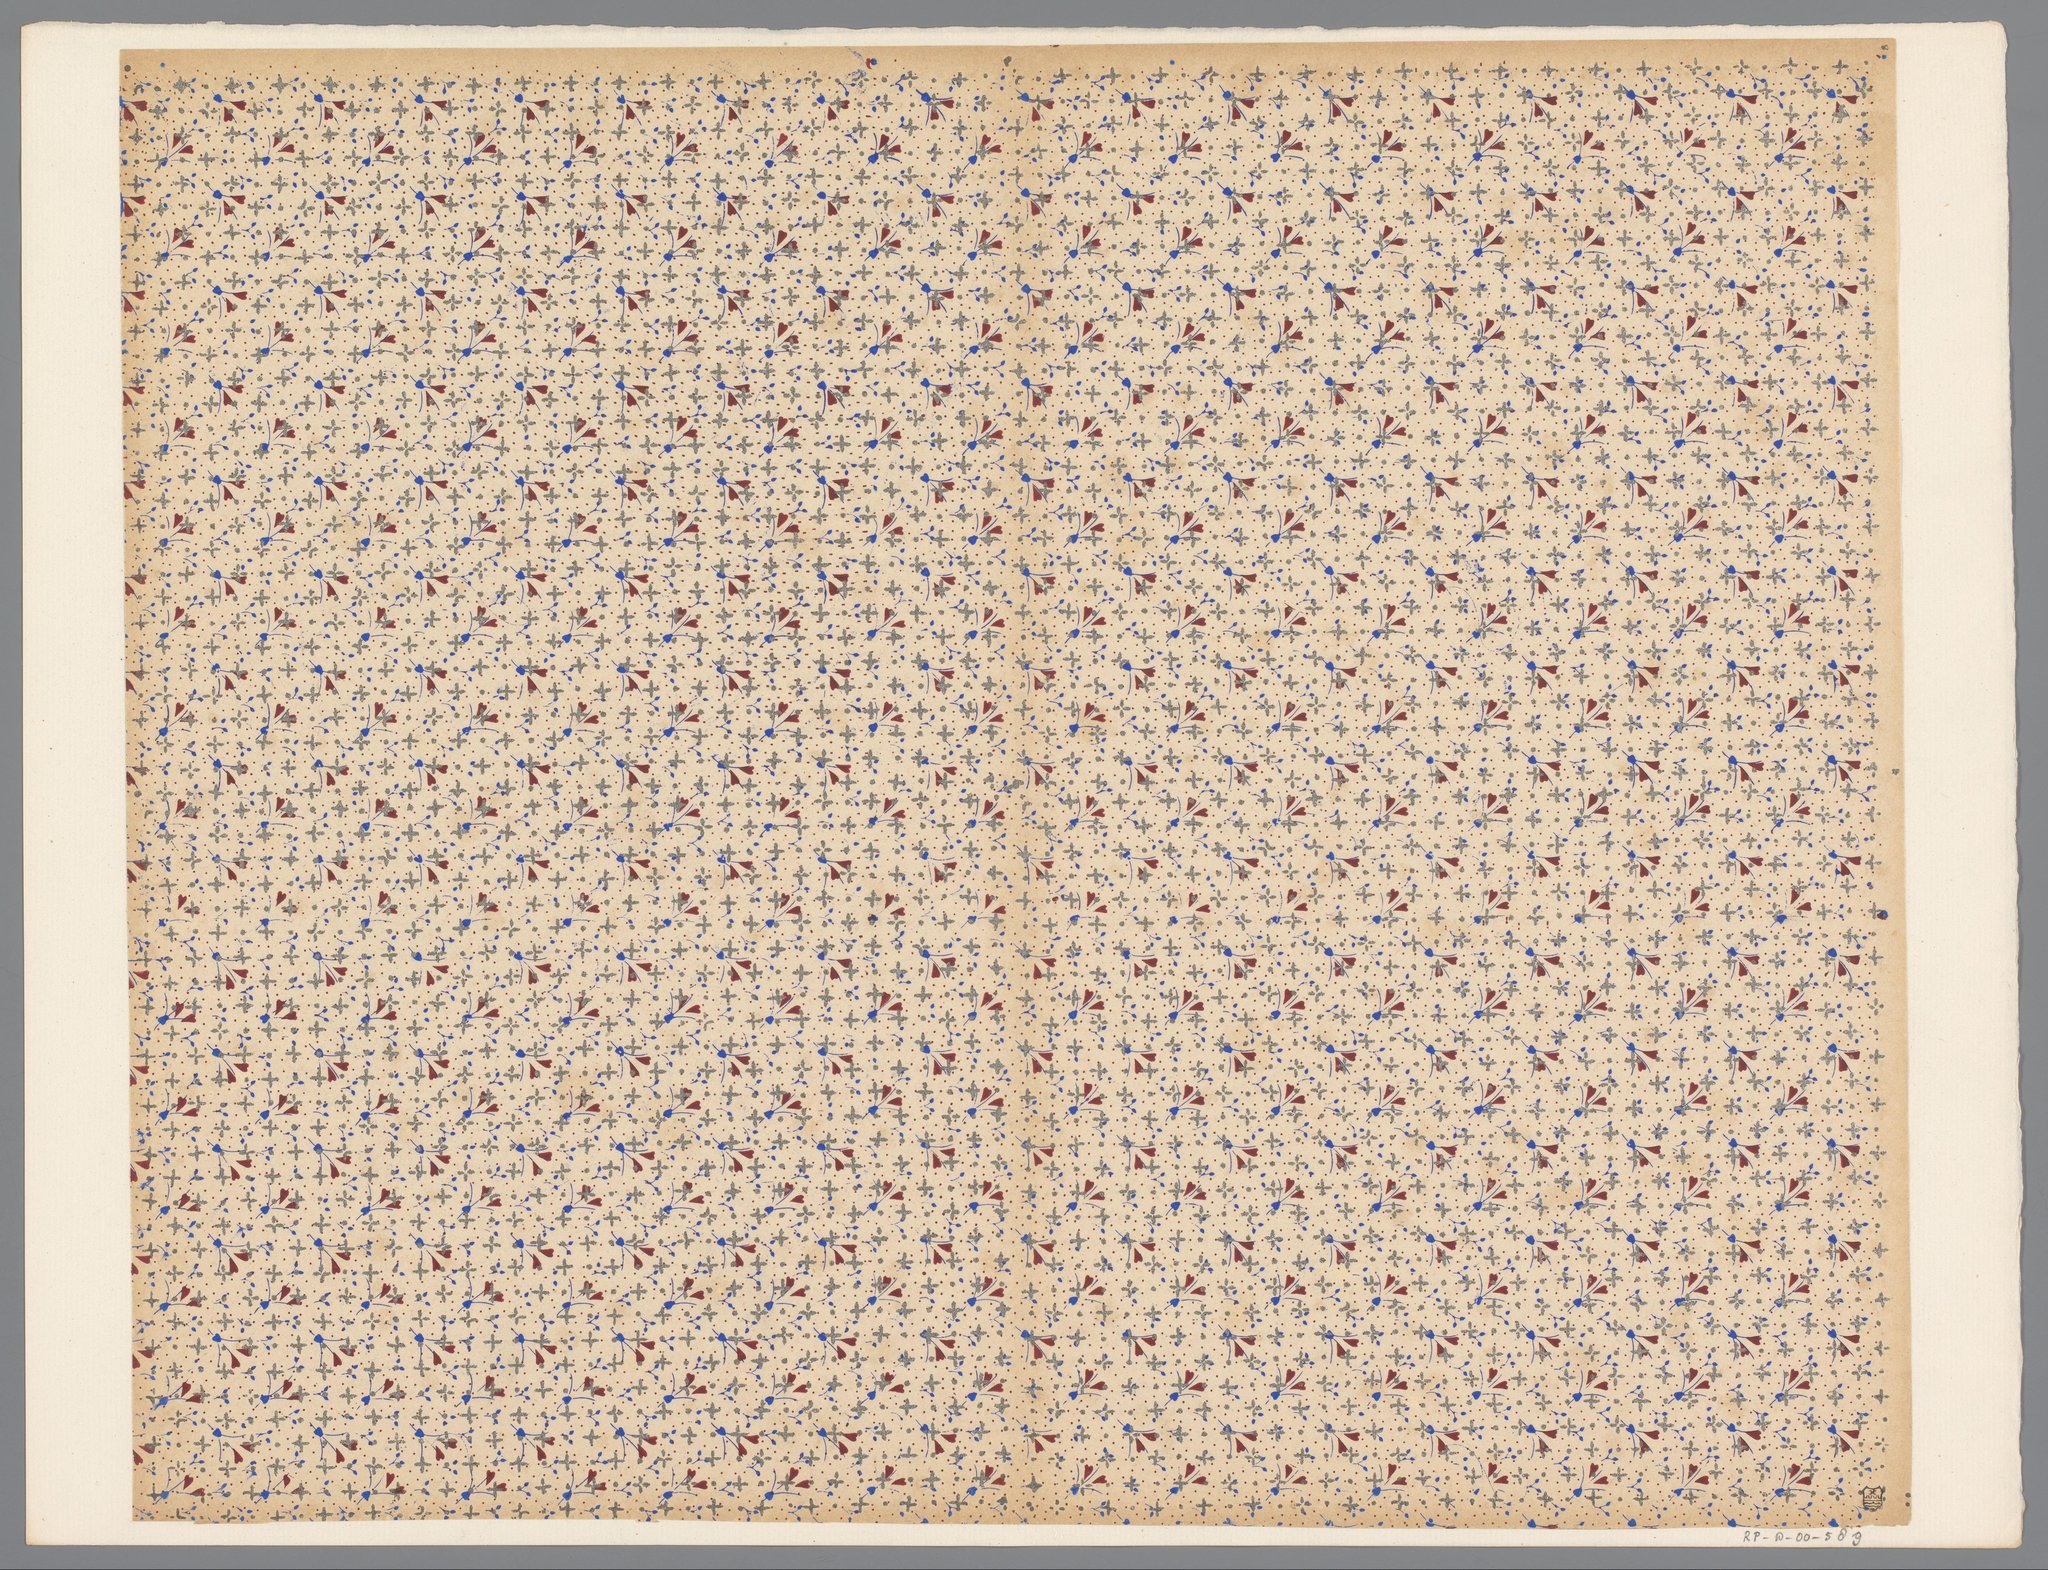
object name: printed paper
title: Blad met alternerend strooipatronen van kruisjes en stippen over bladmotief met puntenfond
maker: Anonymous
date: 1800-1900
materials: paper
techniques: printing block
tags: ornament derived from plant forms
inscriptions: collector's mark: Lugt 2760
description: Blad met alternerend strooipatronen van kruisjes en stippen over bladmotief met puntenfond.